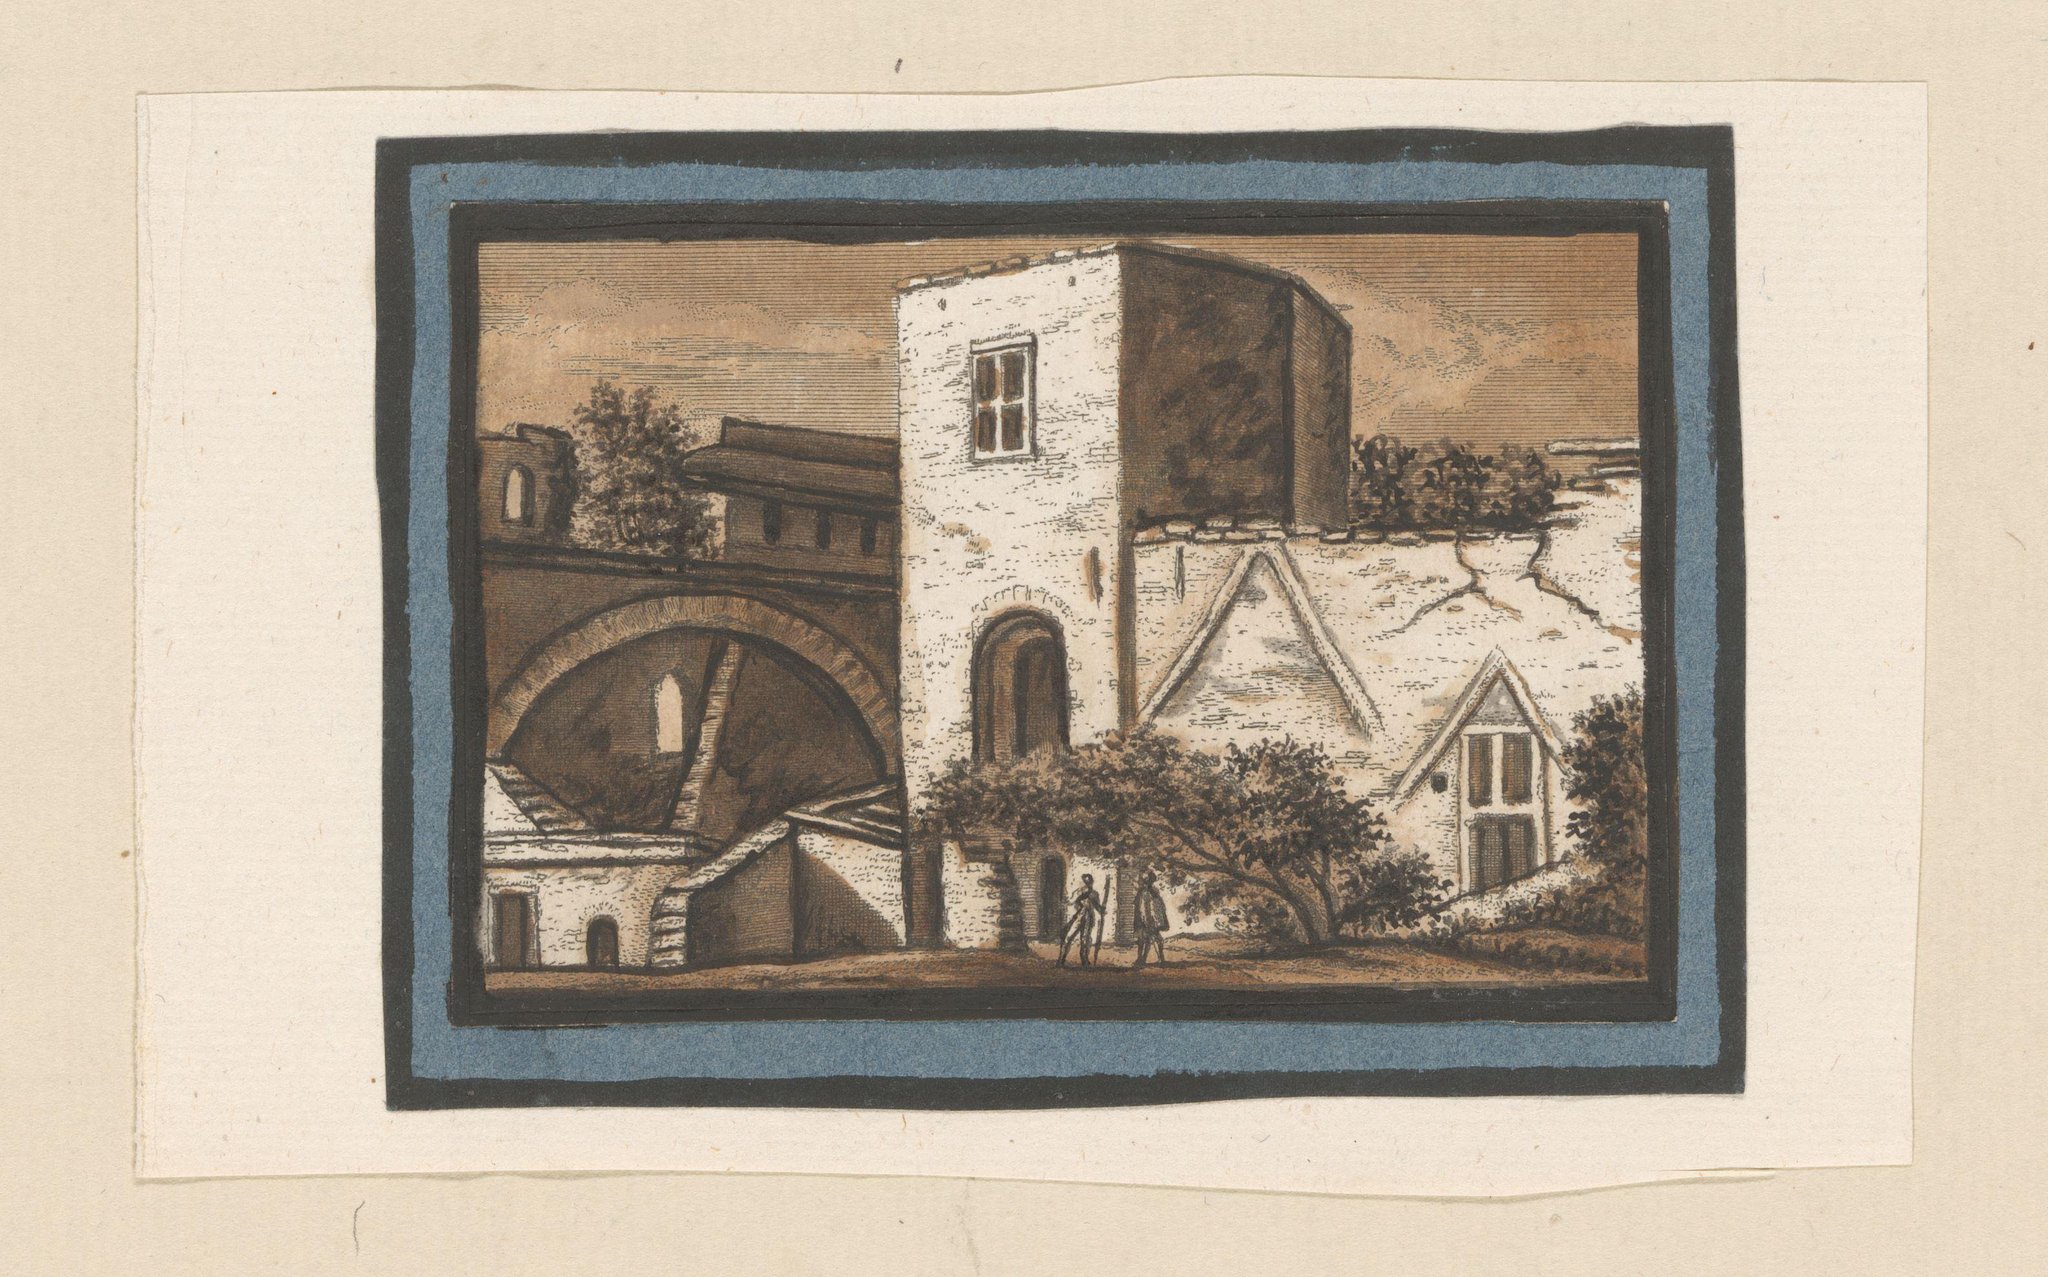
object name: print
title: Gezicht op de binnenzijde van Slot Abcoude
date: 1725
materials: ink, paper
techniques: brush, etching, hand coloring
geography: amsterdam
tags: castle, landscape with tower or castle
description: Een ingekleurd exemplaar van de prent zoals die voorkomt als nr. 245 in: Rademaker, Abraham. Kabinet van Nederlandsche outheden en gezichten (...). Amsterdam: Willem Barents, 1725.